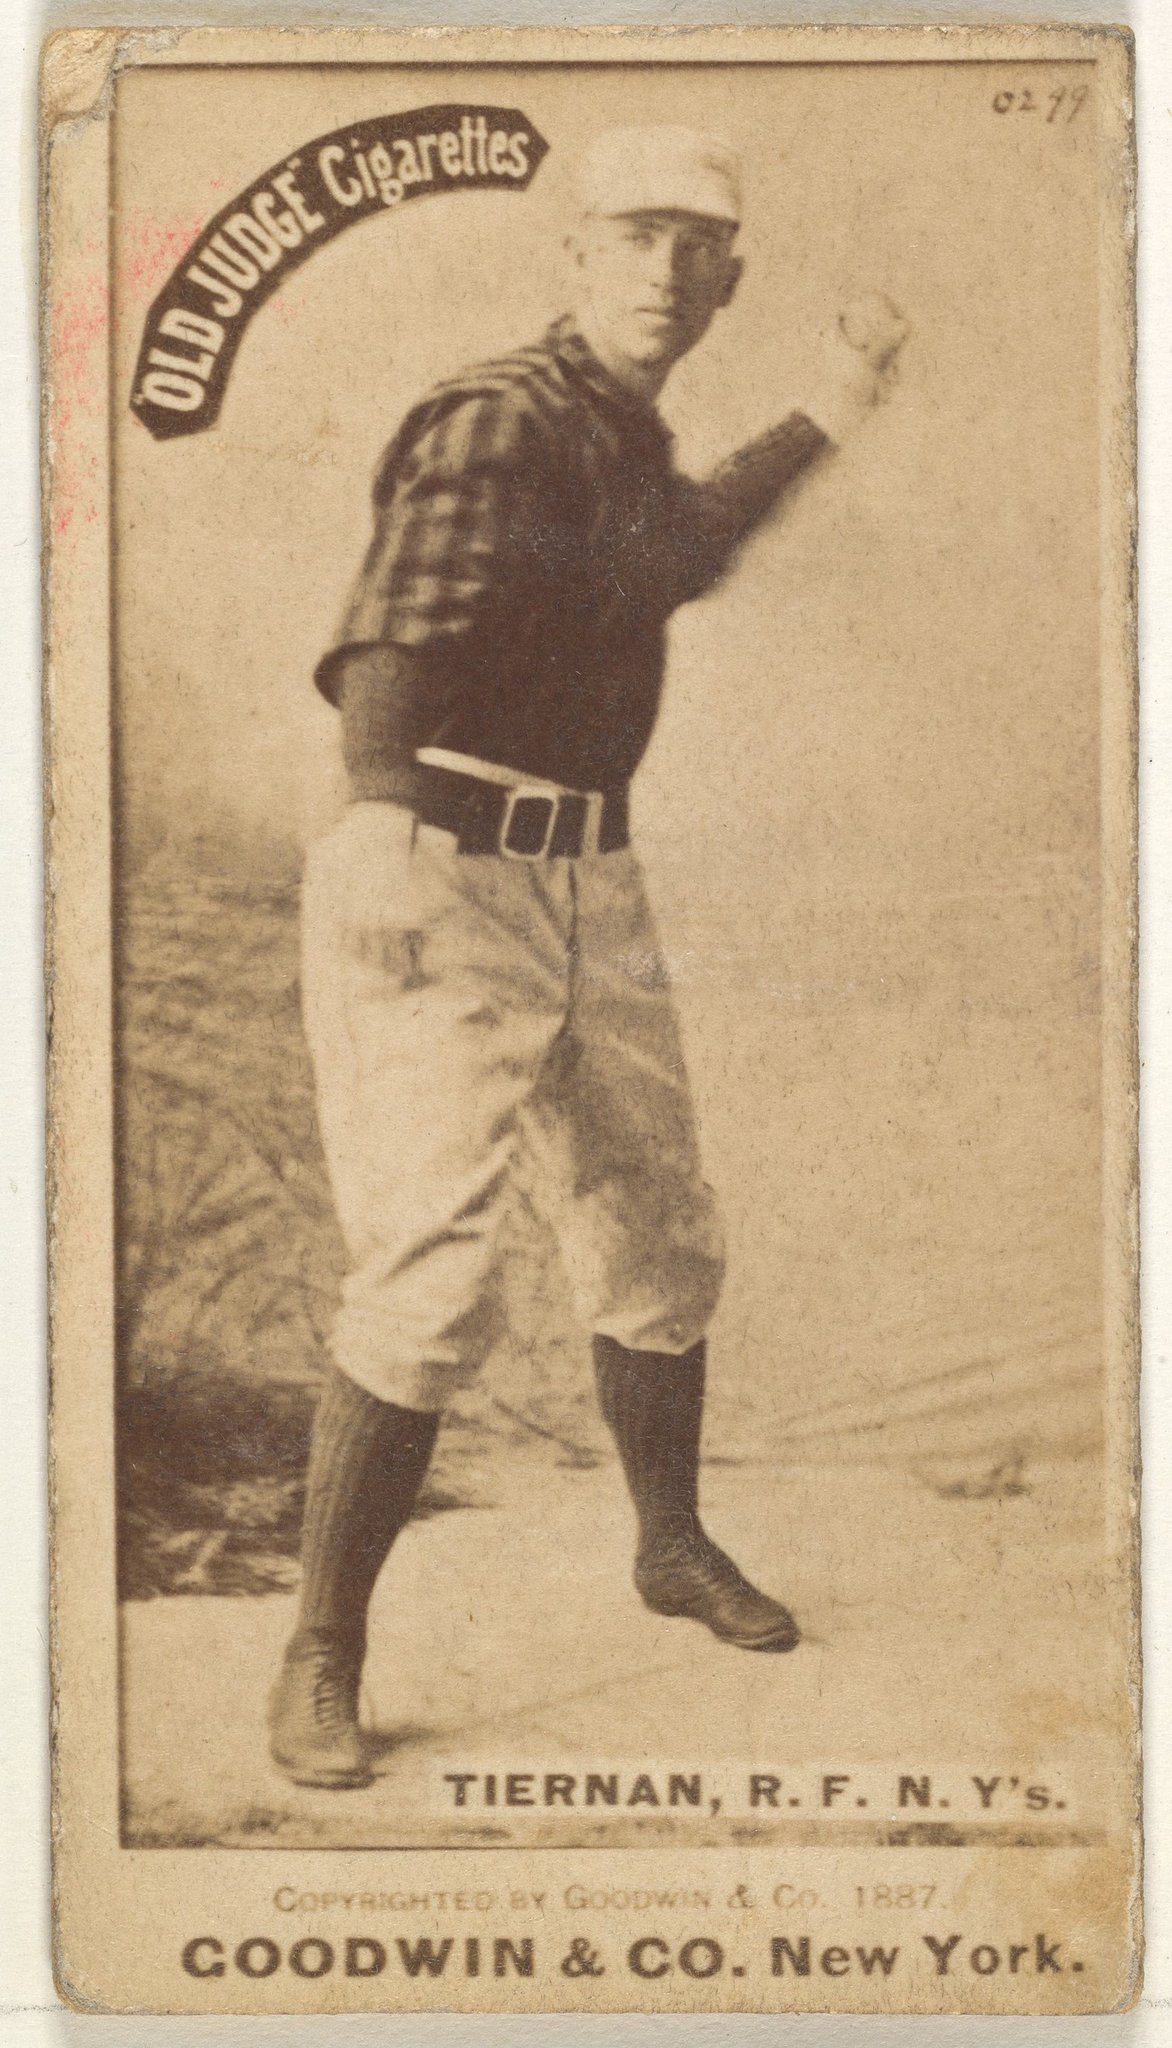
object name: baseball card, photograph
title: Michael "Silent Mike" Joseph Tiernan, Right Field, New York, from the Old Judge series (N172) for Old Judge Cigarettes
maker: goodwin & company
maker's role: publisher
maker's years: 1850-1950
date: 1887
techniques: albumen silver print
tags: men,portraits,baseball,athletes